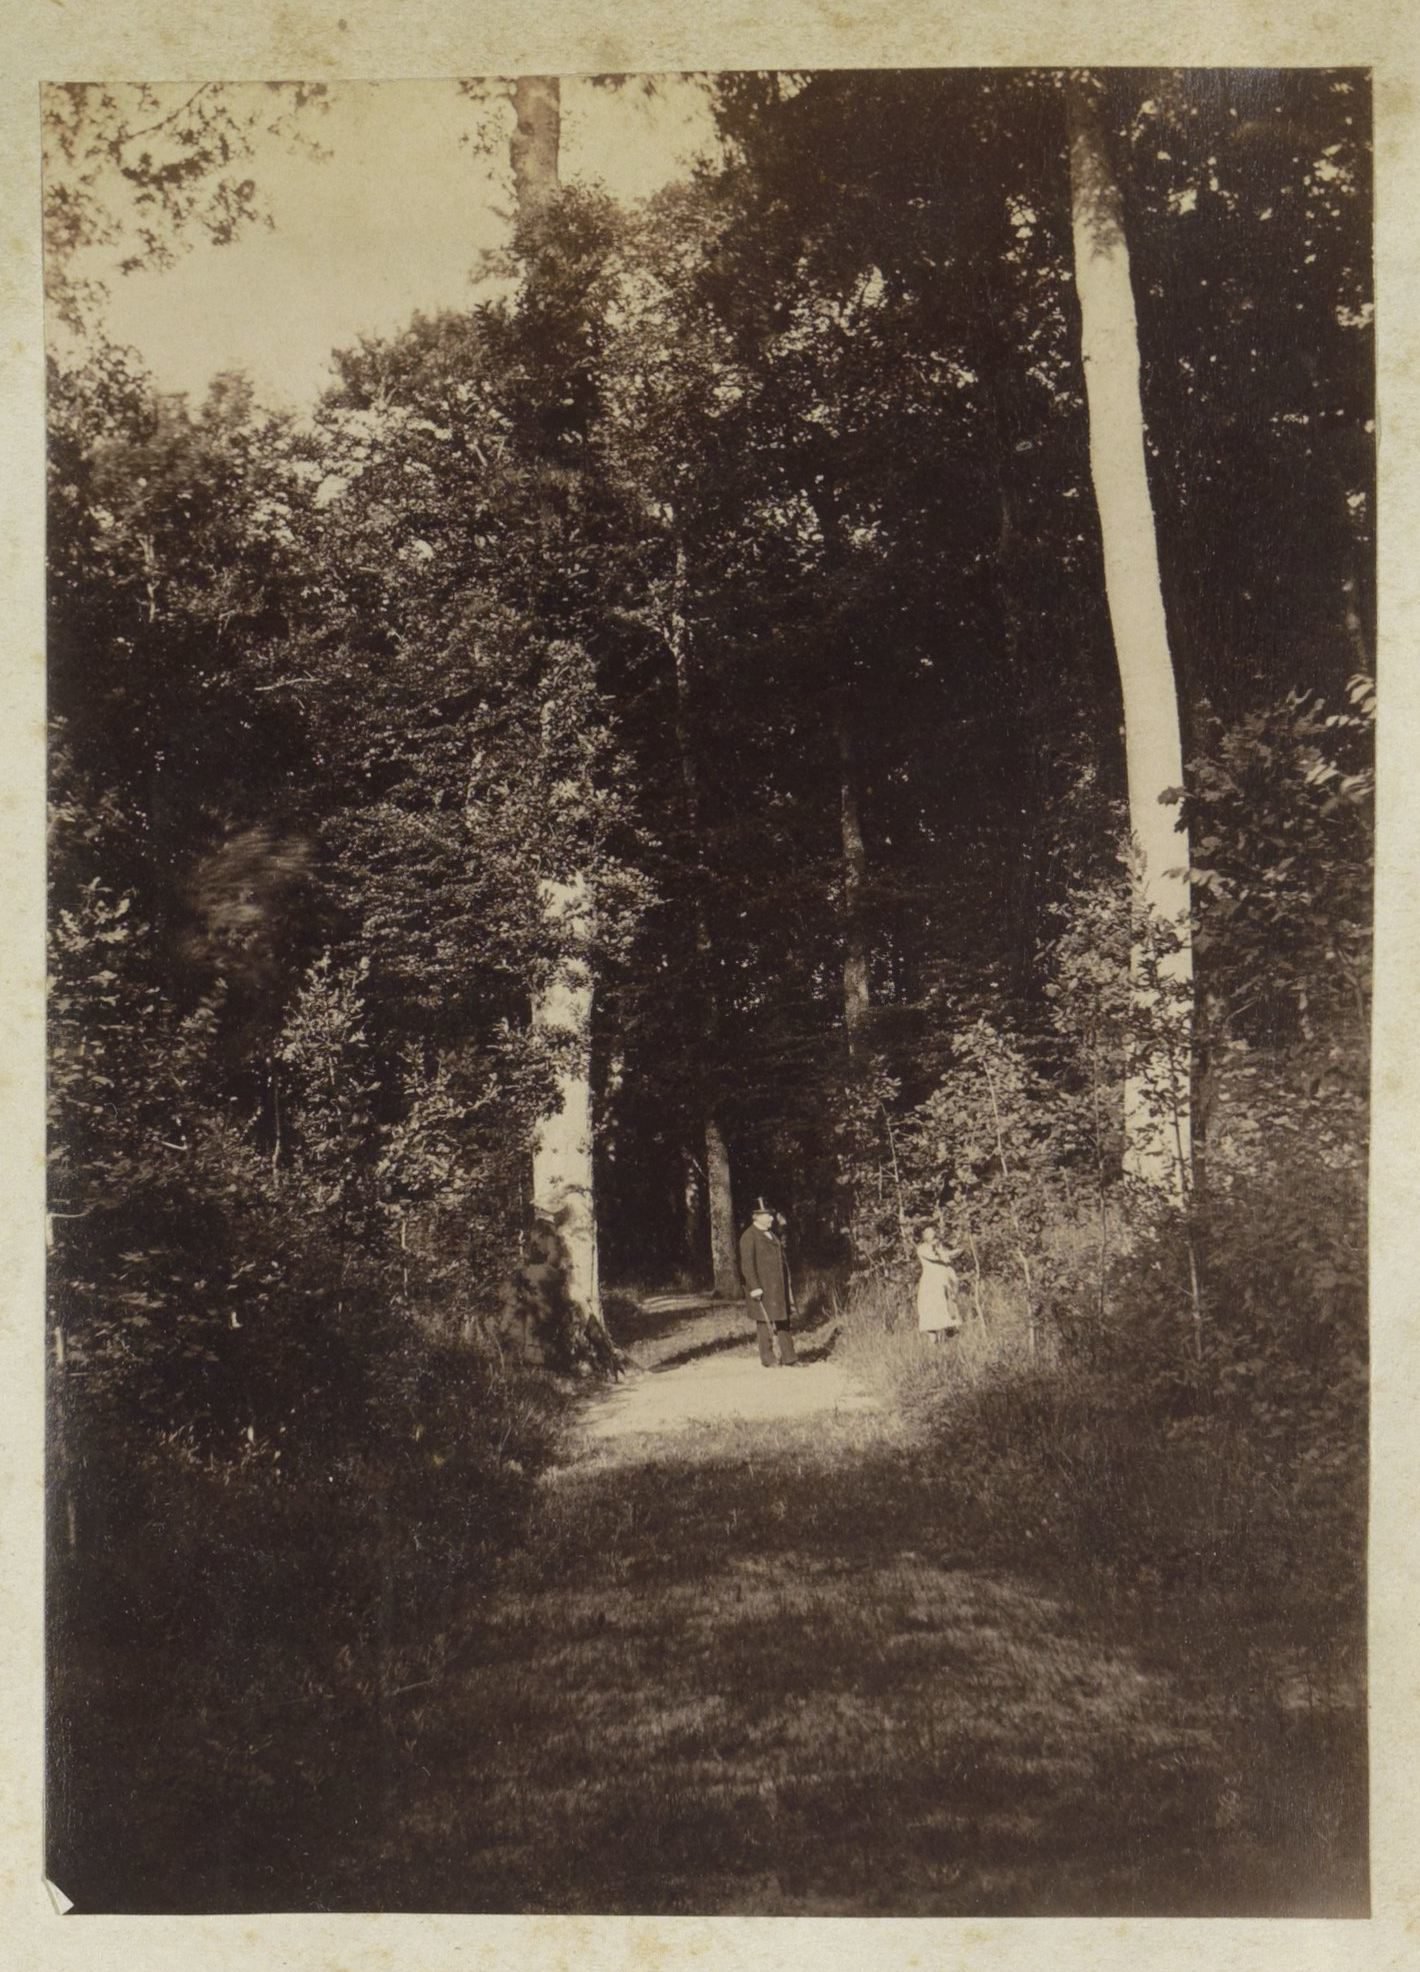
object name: photograph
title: Man en een kind op een bospad in Frankrijk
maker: Anonymous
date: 1808-1883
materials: photographic support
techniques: albumen print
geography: france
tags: forest path or lane, france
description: Onderdeel van Album van een Franse amateurfotograaf met opnames van familie, militairen, industrie, landschappen en bezienswaardigheden in Frankrijk.